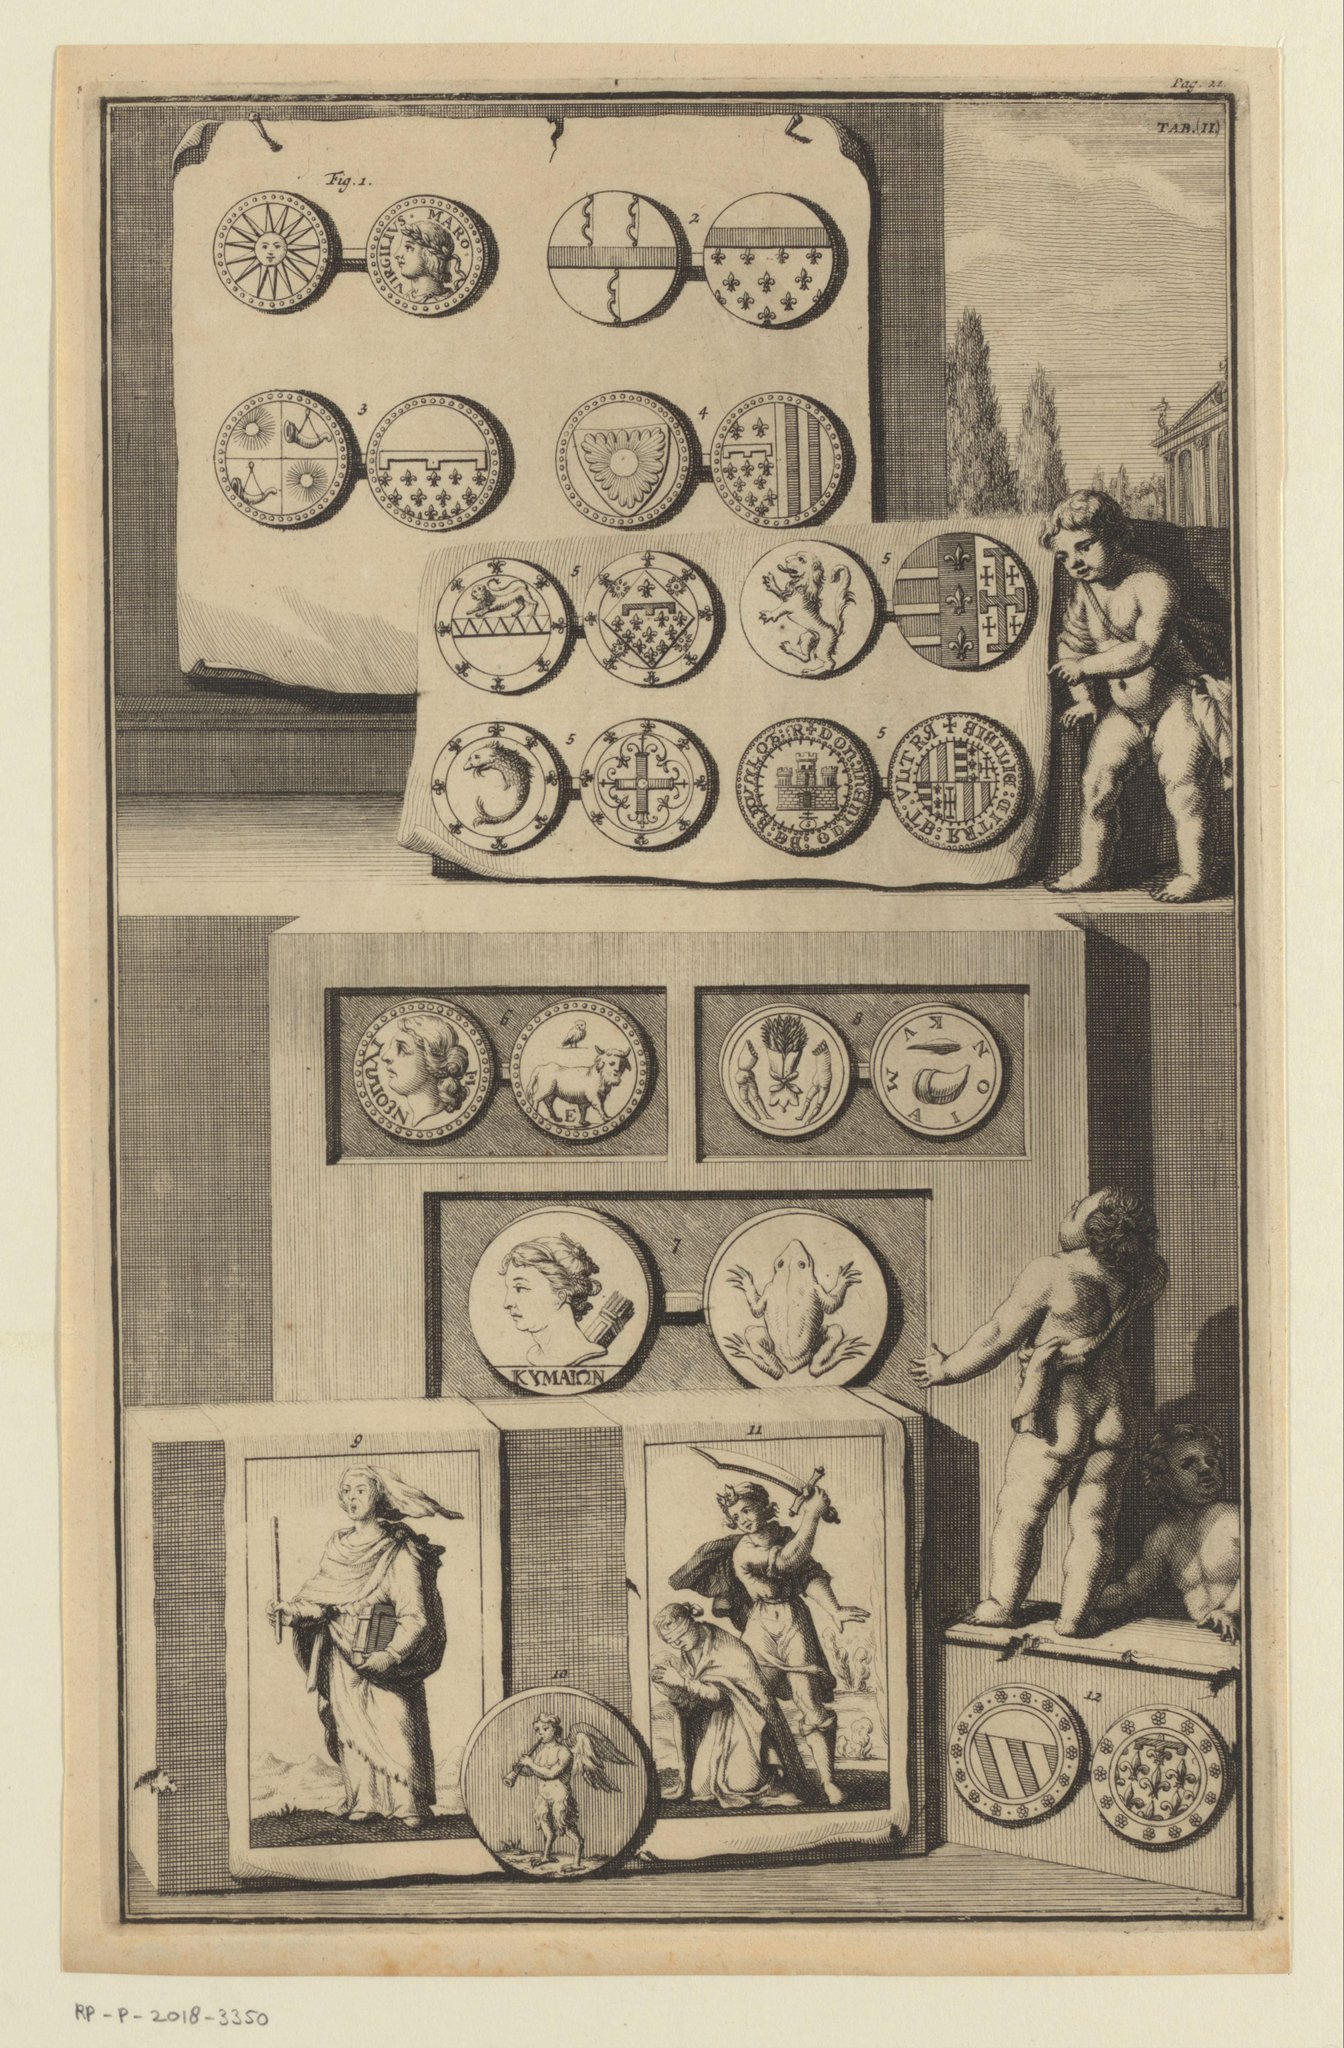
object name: print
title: Compositie met munten en reliëfs, mogelijk met wapenschilden en tekeningen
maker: Anonymous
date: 1700-1799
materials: paper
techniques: engraving, etching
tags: tailless amphibians: frog, coin, armorial bearing, heraldry, sculpture (+ relief ~ sculpture)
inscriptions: collector's mark: Lugt 2228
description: Prent uit een onbekend boek met objecten, kunstwerken en figuren uit de Romeinse geschiedenis en religie. Dit betreft een illustratie bij p. 21.